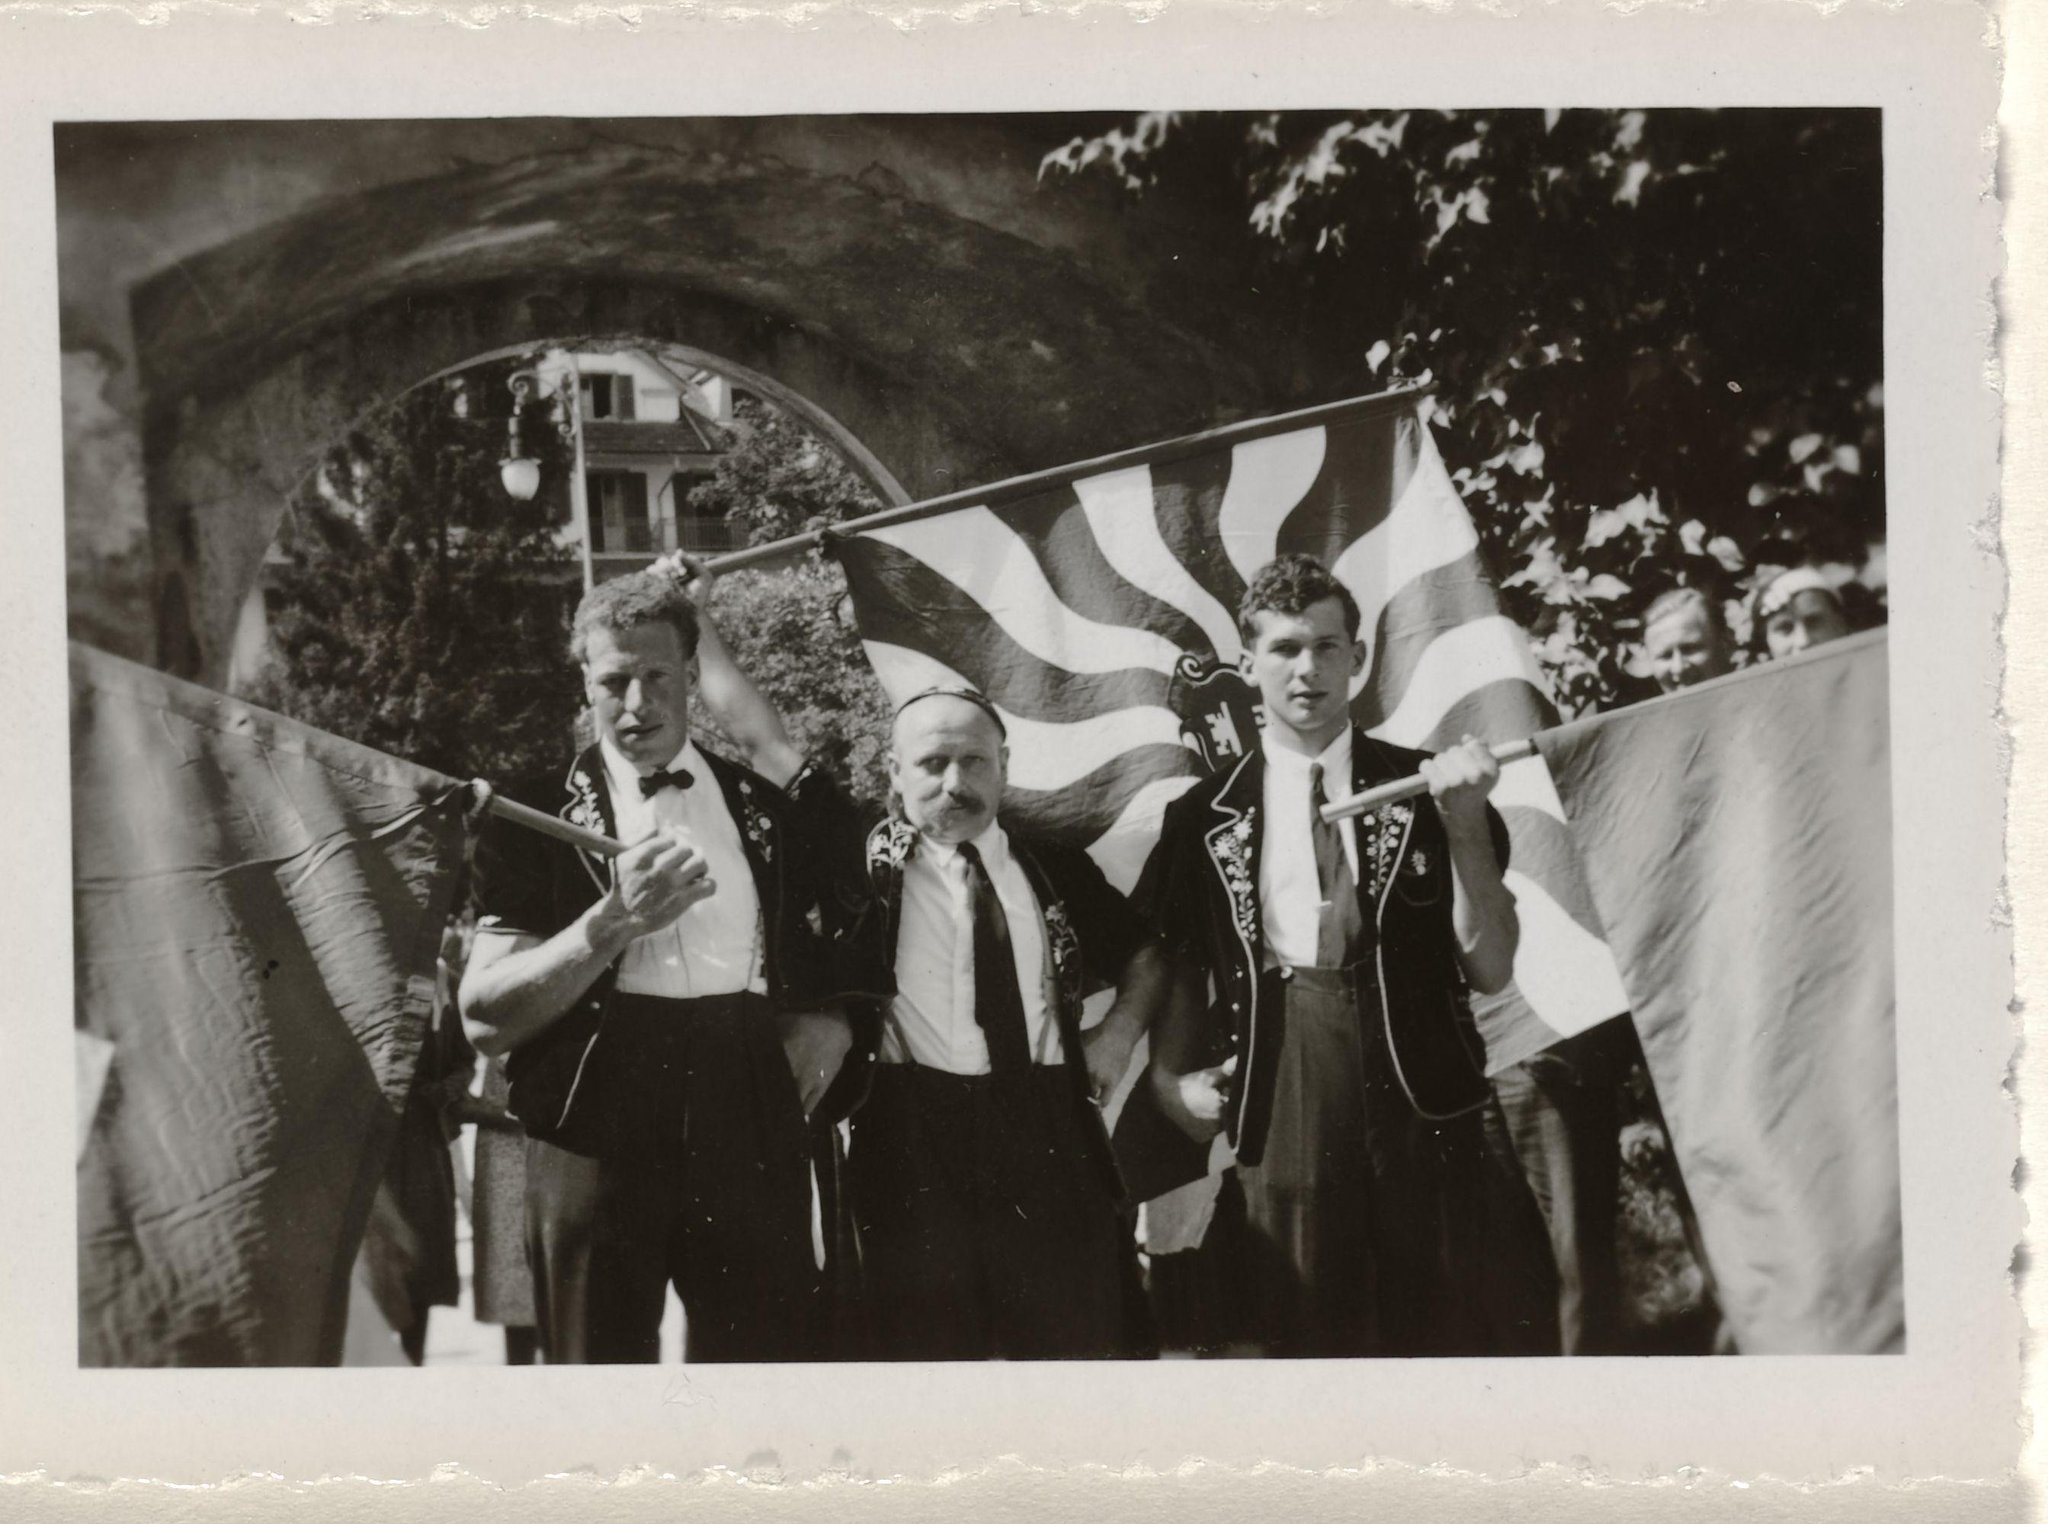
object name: photograph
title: Drie mannen in klederdracht met vaandels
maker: Anonymous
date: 1930-1965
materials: photographic support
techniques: gelatin silver print